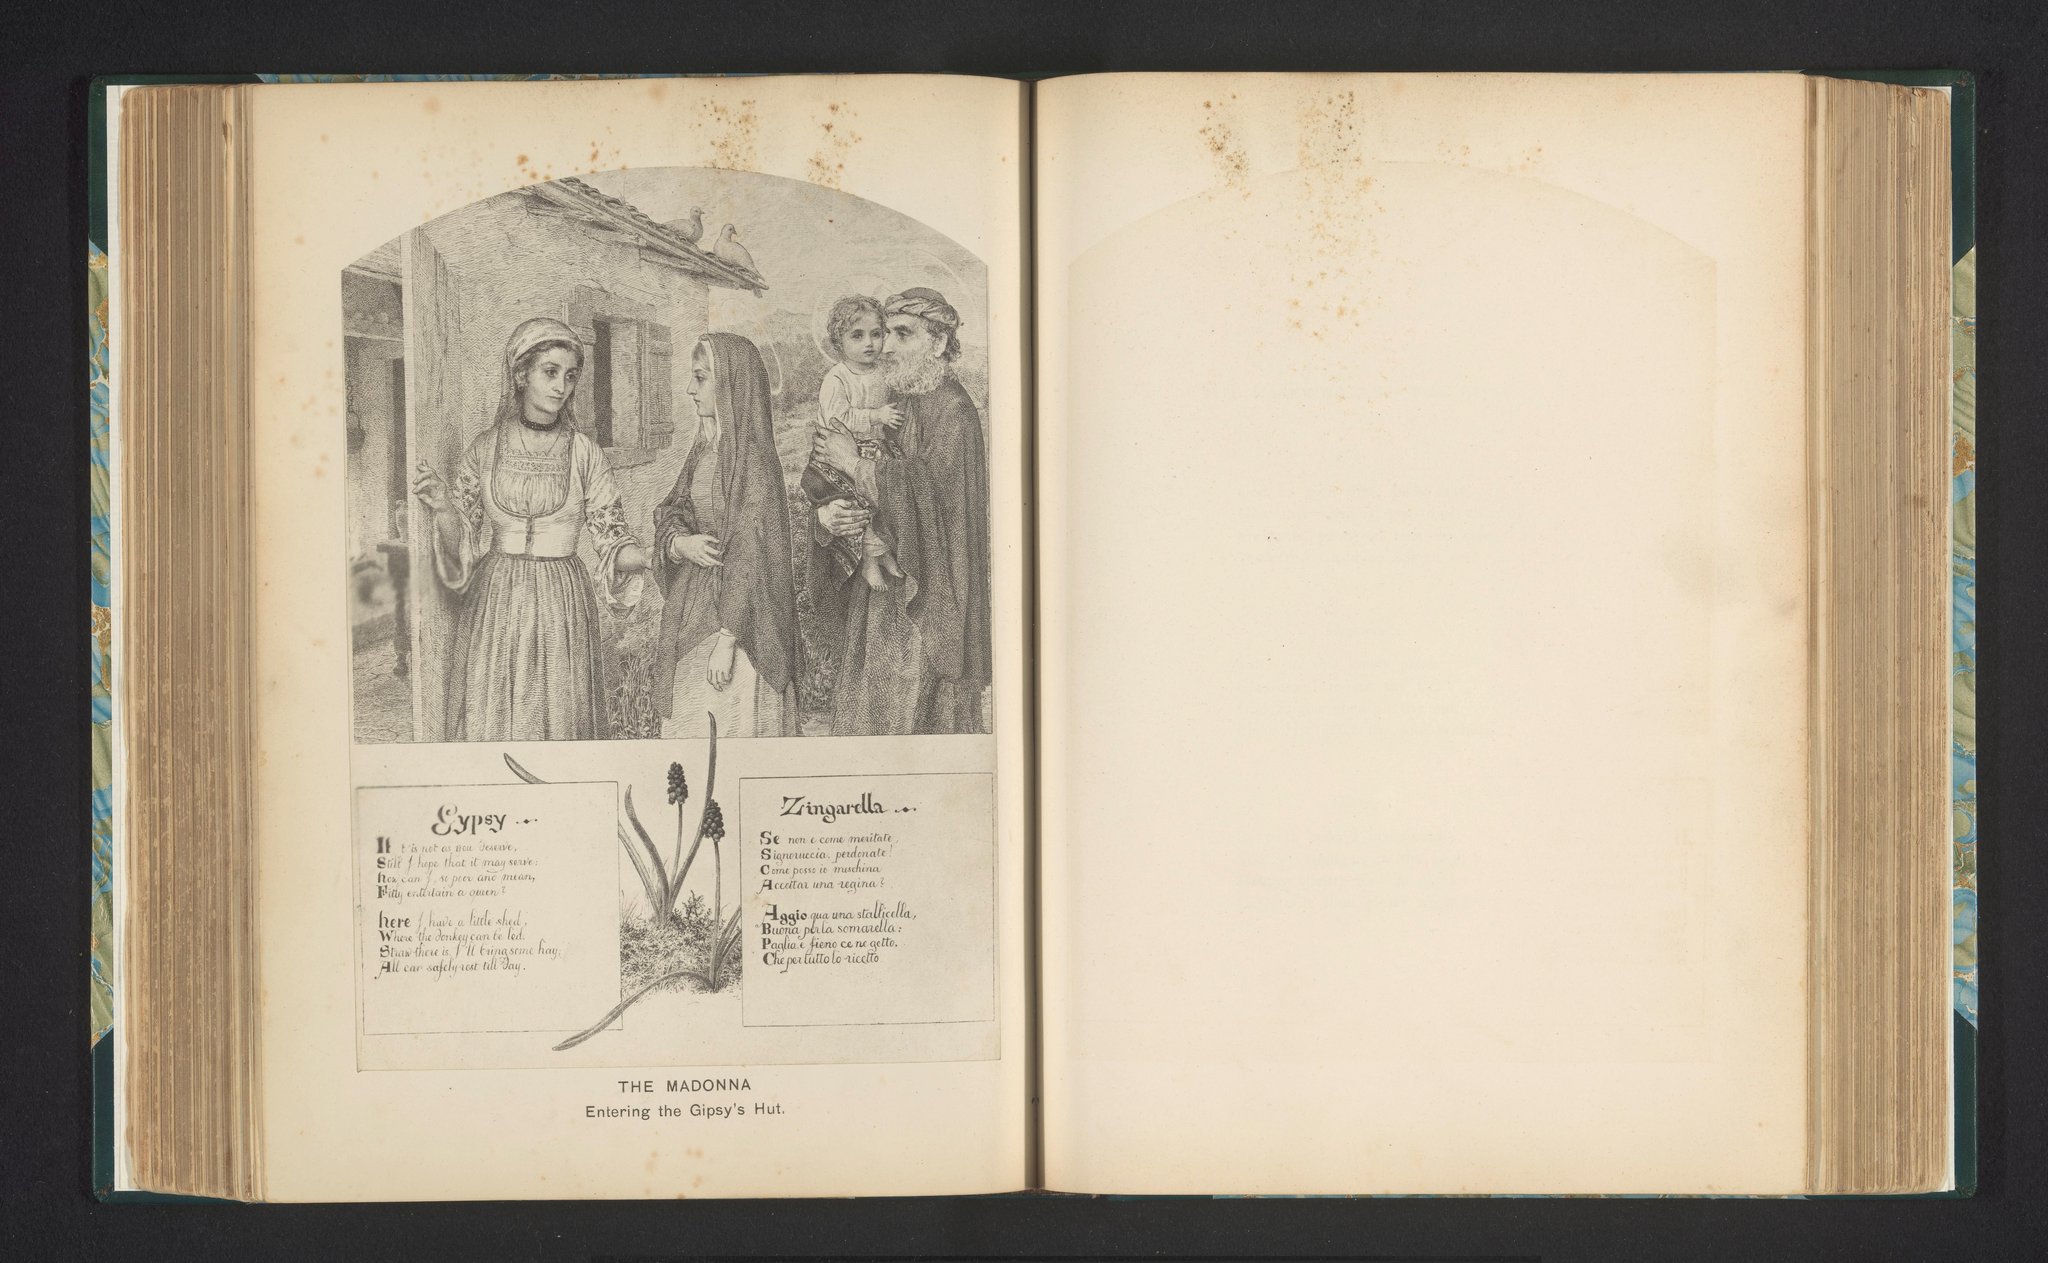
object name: reproduction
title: The gypsy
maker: frederick hollyer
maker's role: fotograaf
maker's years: 1838-1933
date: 1875-1885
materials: photographic support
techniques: platinum process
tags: holy family, and derived representations, wandering communities: romani or roma, shed